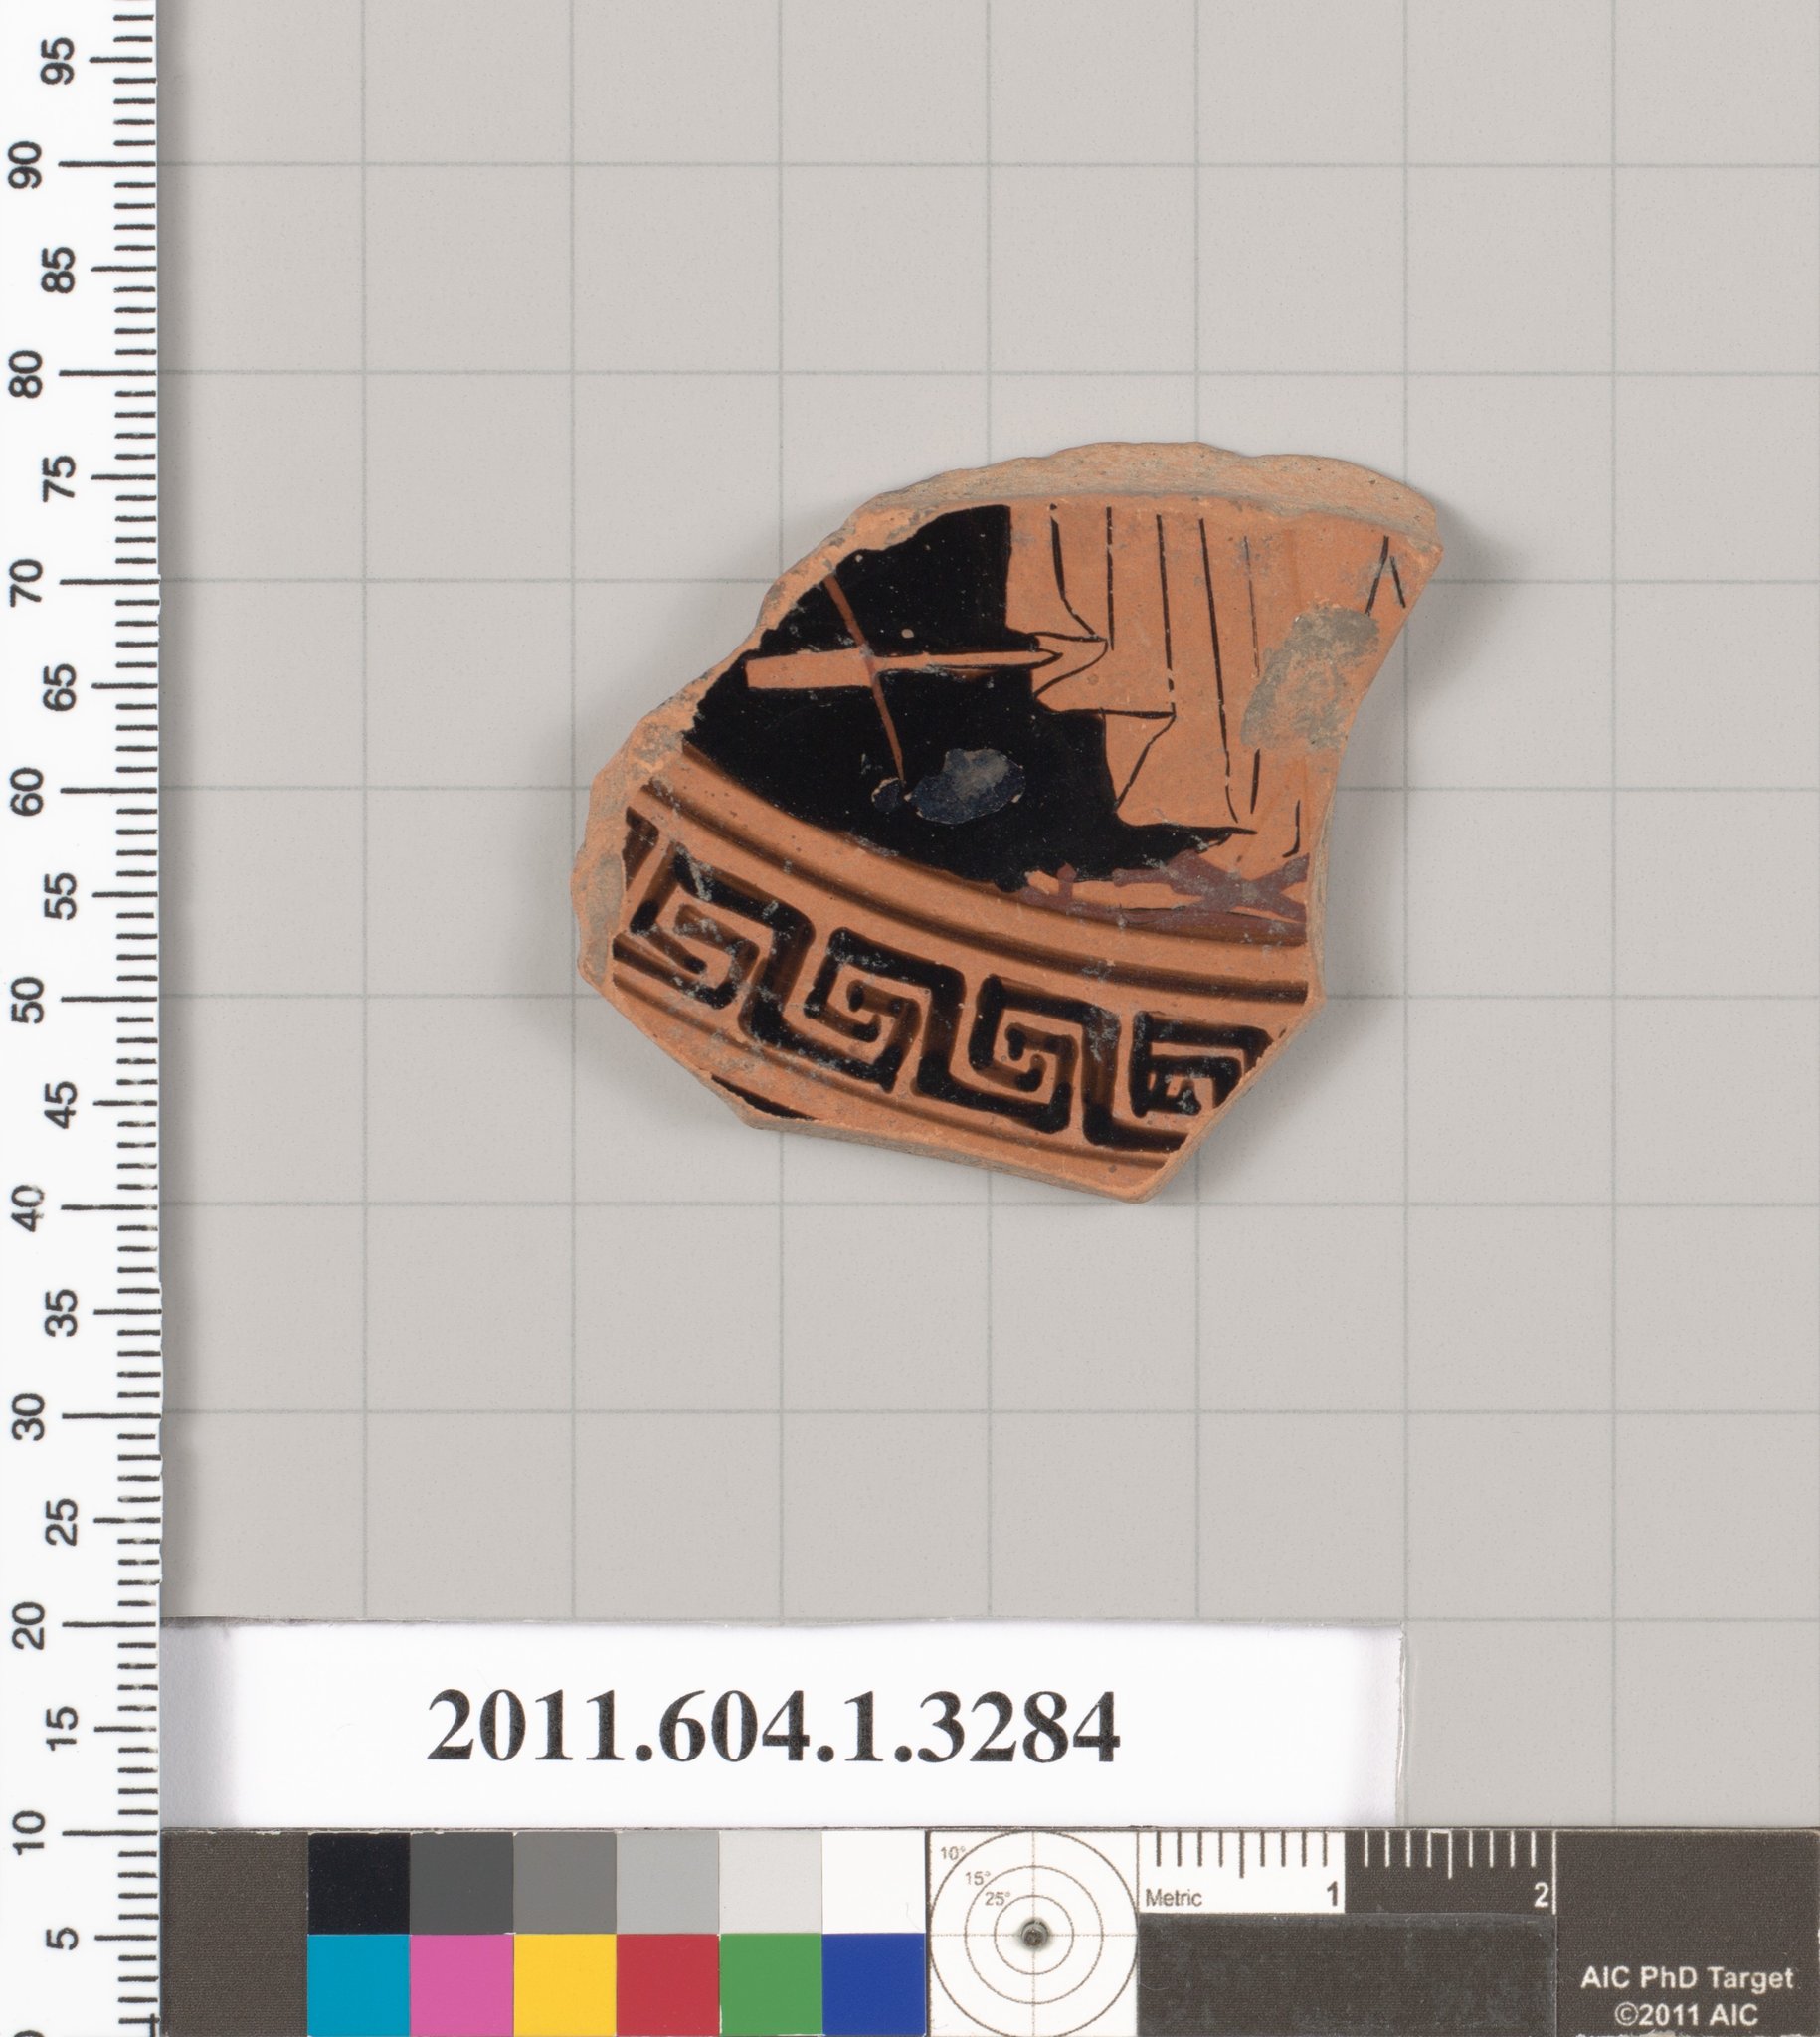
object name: kylix fragment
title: Terracotta fragment of a kylix (drinking cup)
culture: greek, attic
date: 500-476 BCE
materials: terracotta